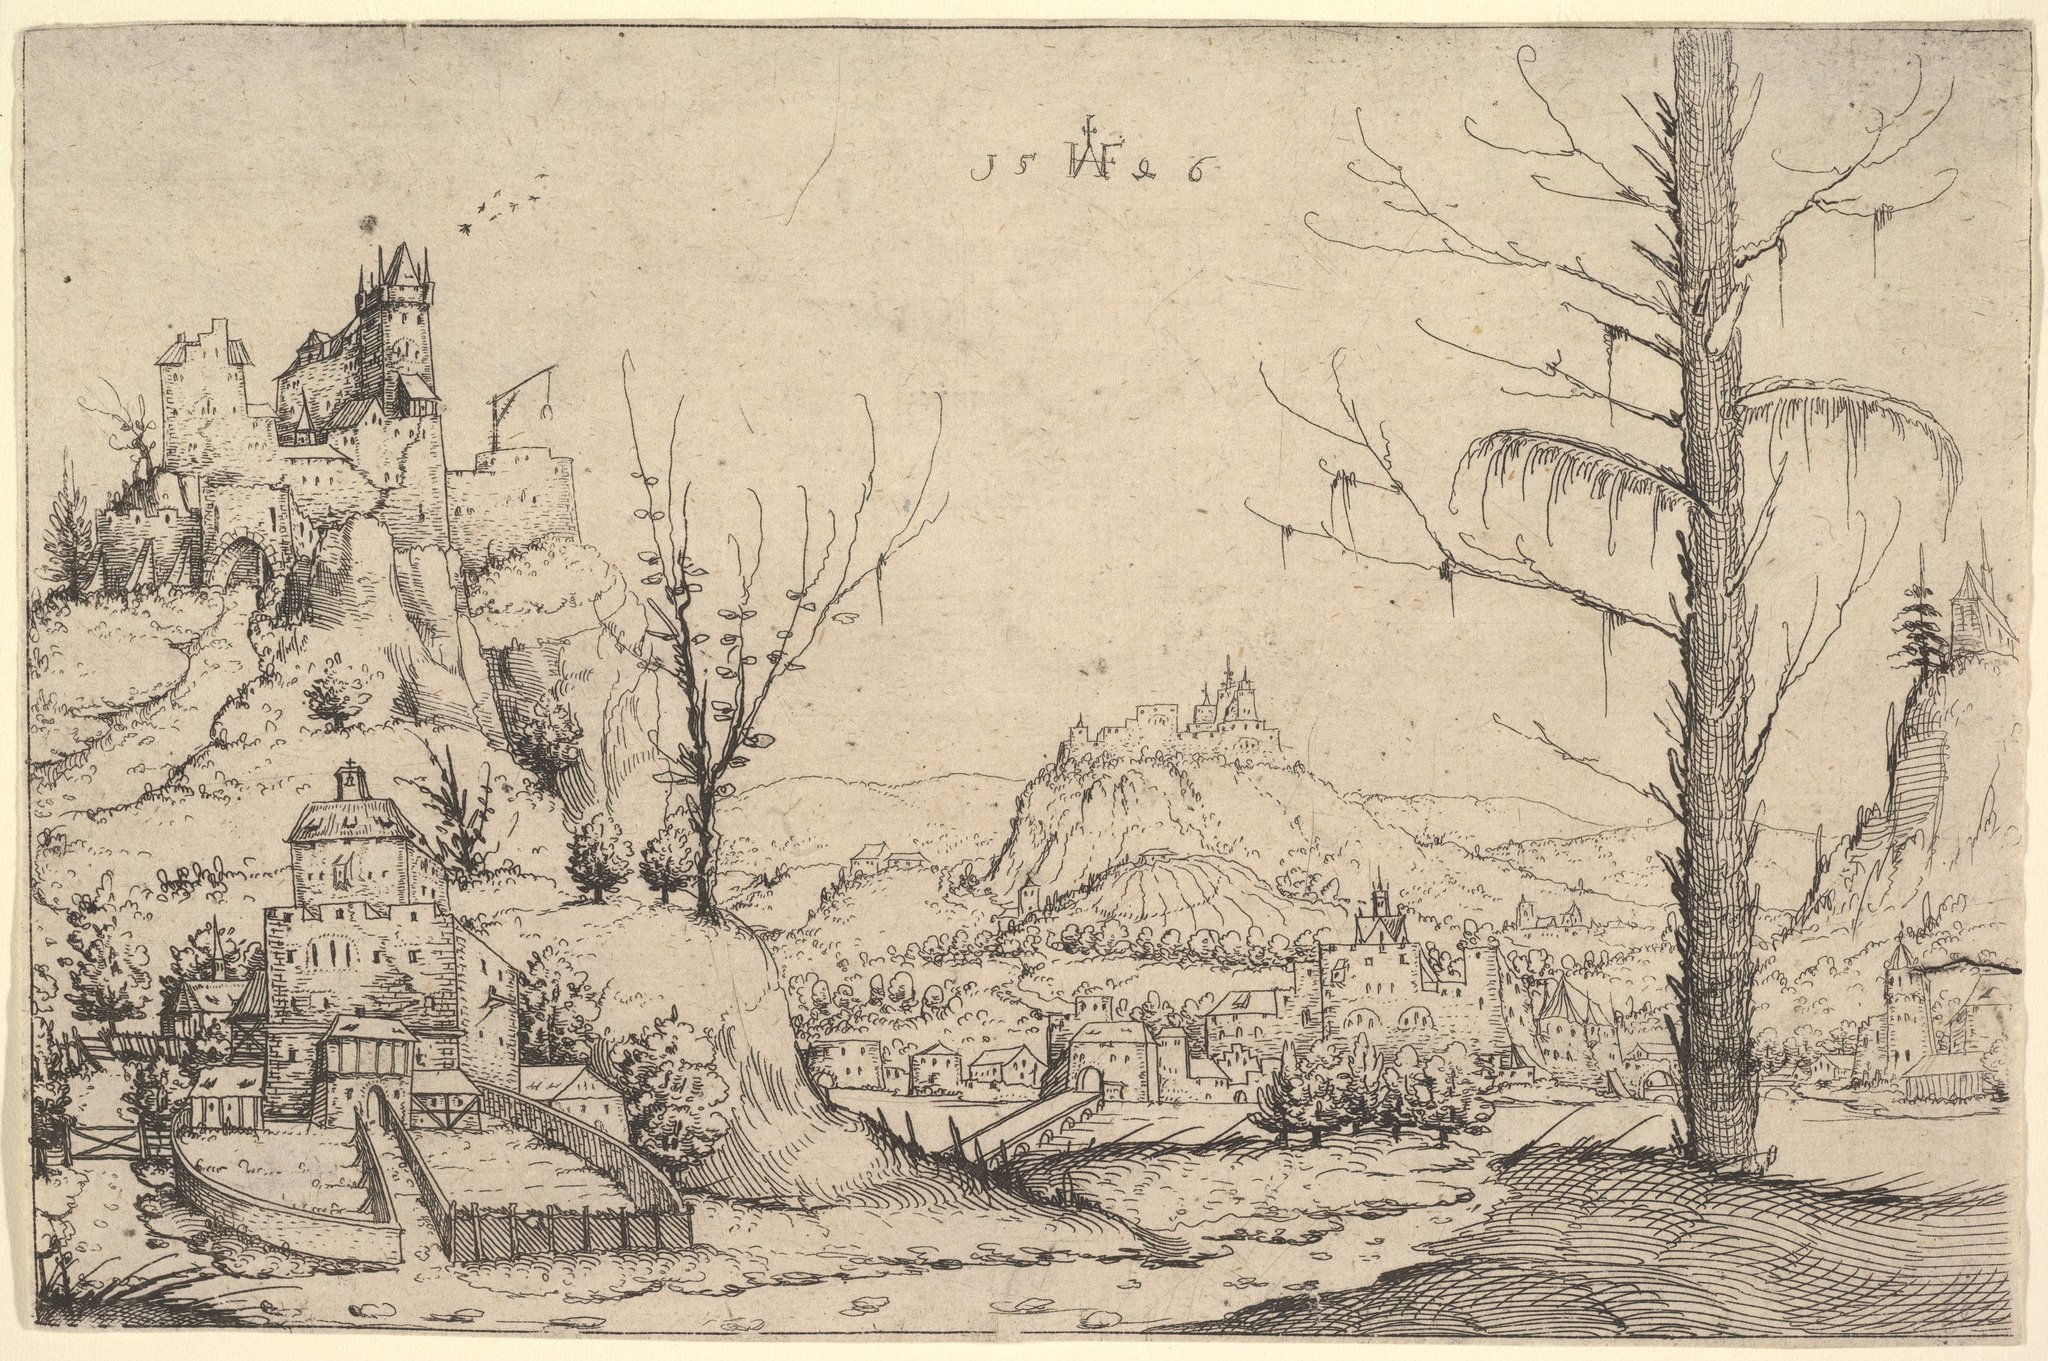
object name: print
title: Landscape with a High Rock and a Castle at Left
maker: augustin hirschvogel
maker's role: artist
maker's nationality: german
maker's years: 1503-1553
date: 1546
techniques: etching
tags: towns,landscapes